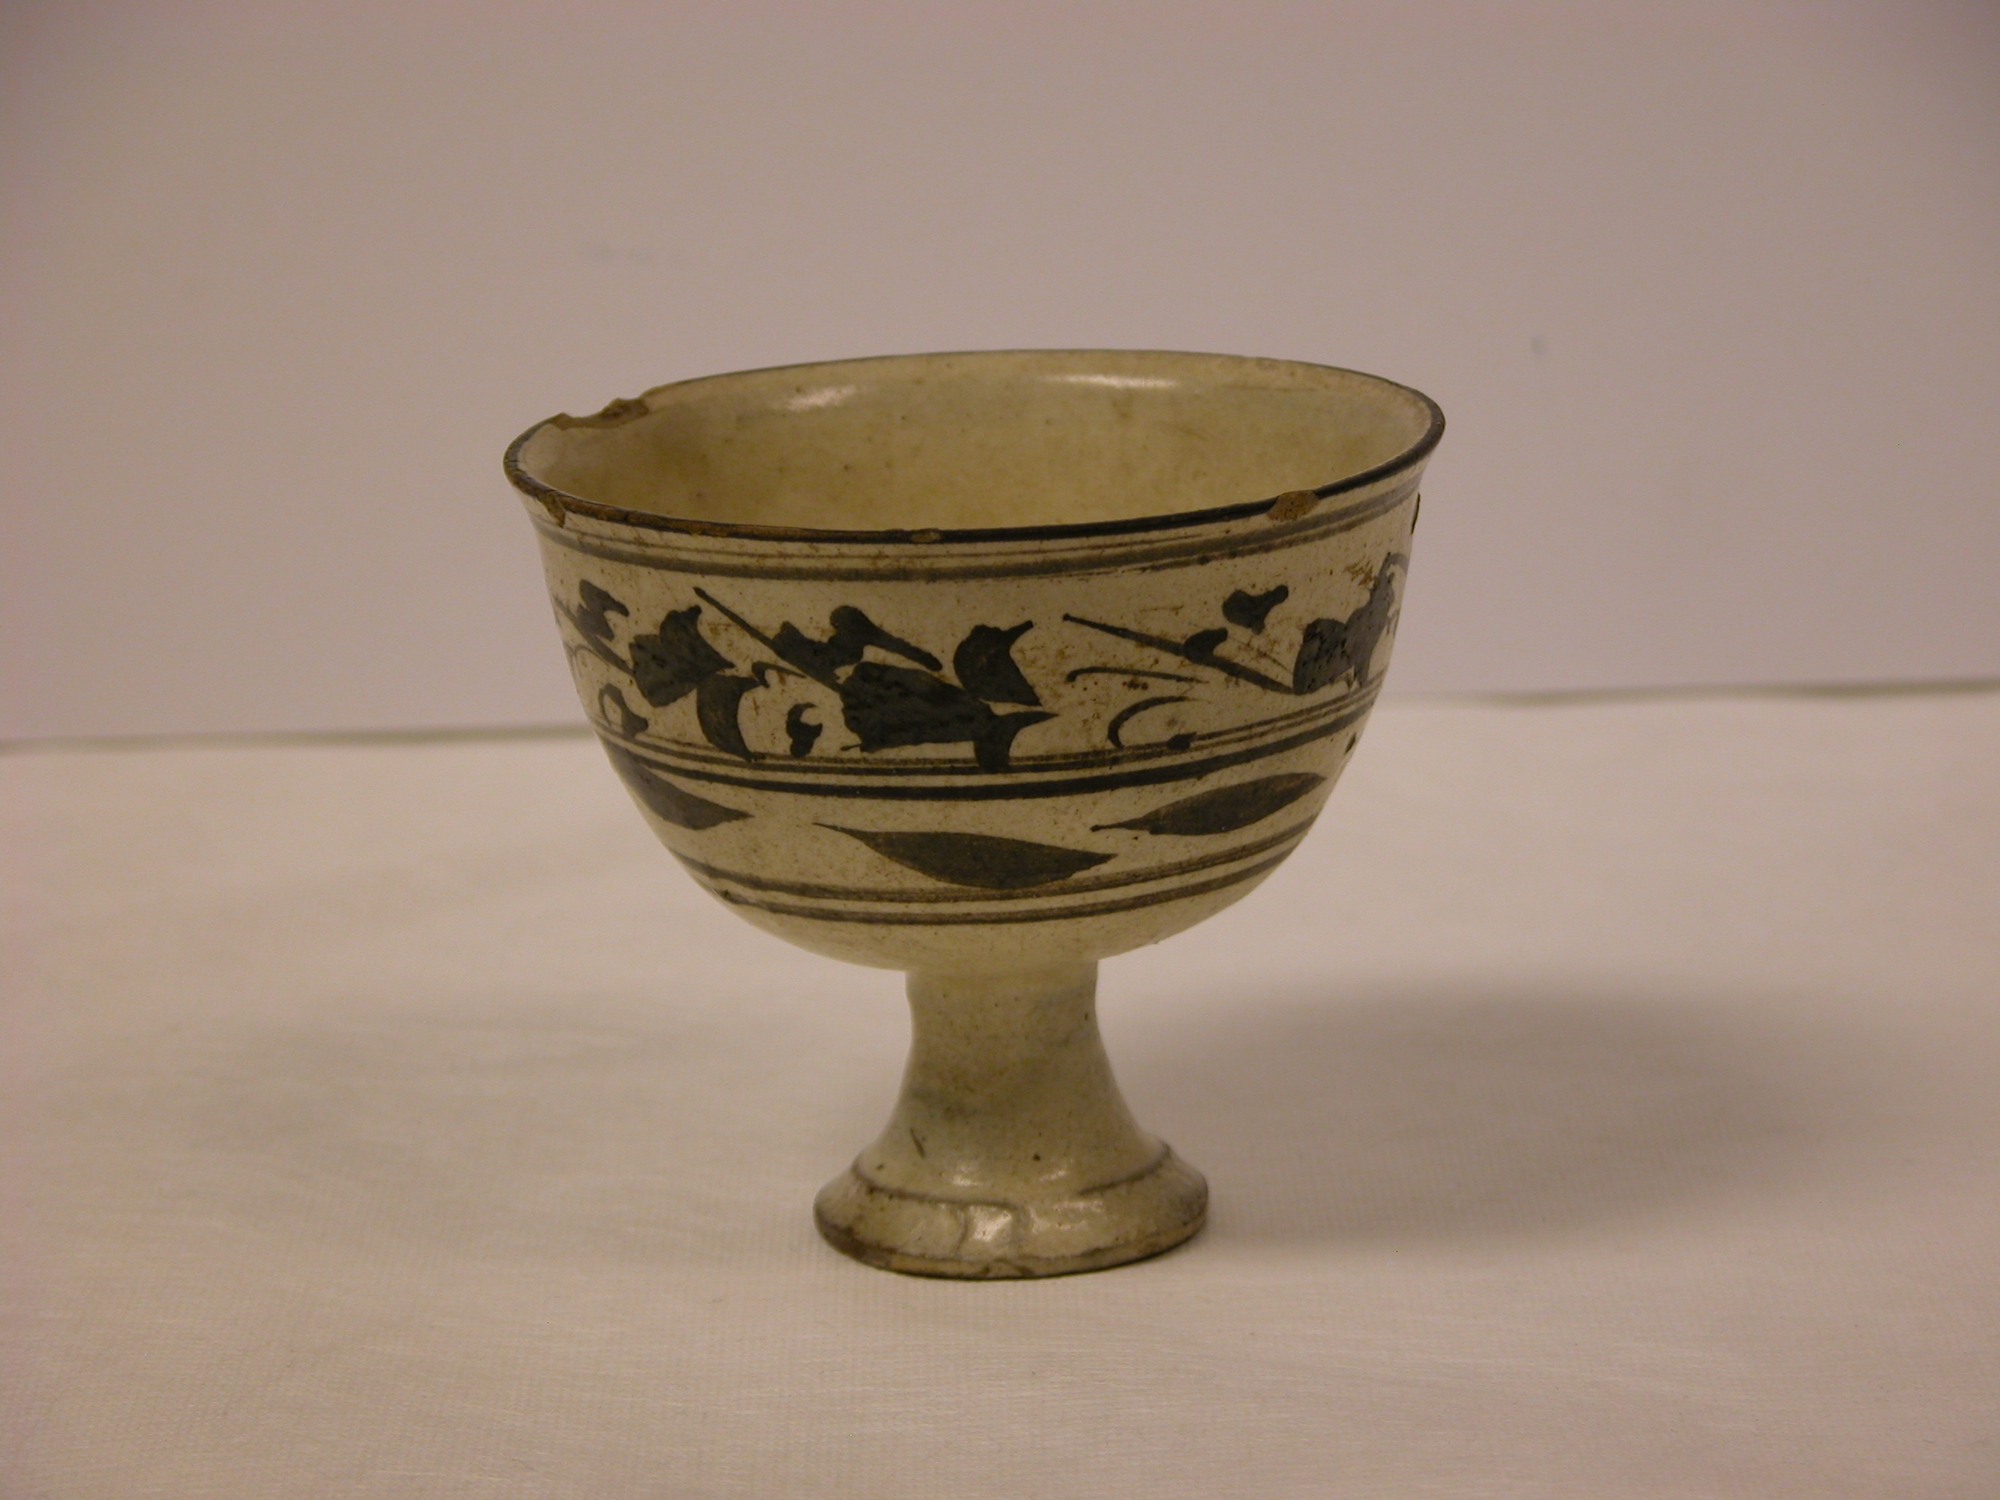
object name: cup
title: Cup on High Foot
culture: chinese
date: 960-1279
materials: pottery